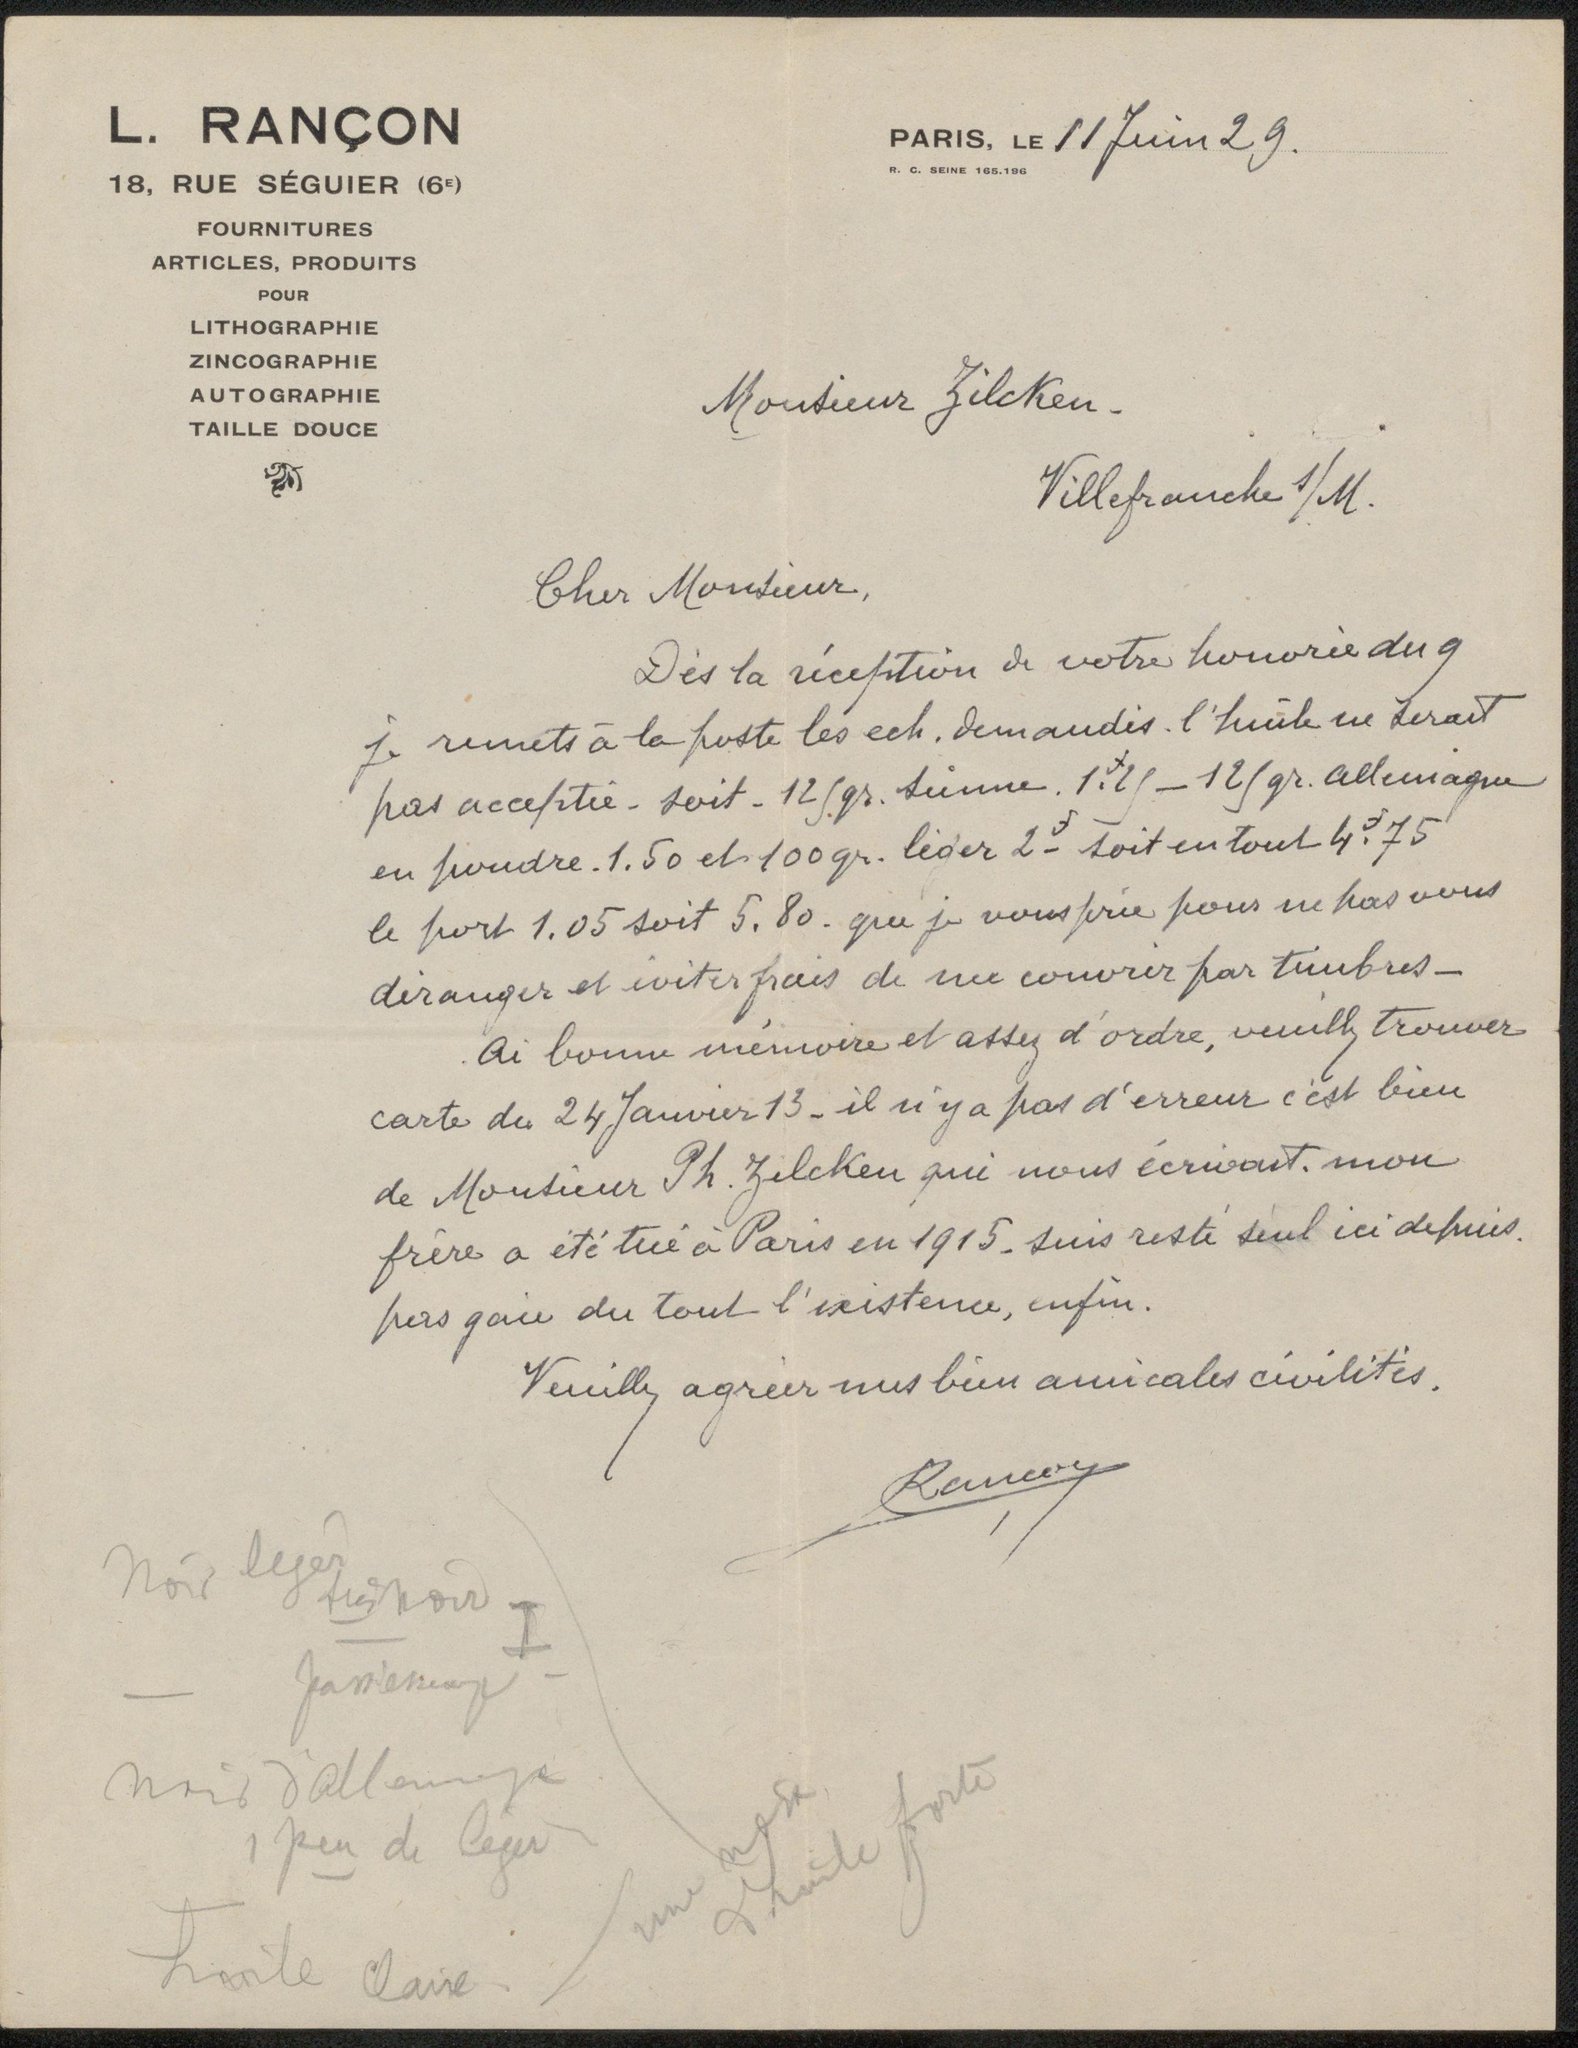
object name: letter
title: Brief aan Philip Zilcken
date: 1929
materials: ink, paper, pencil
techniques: pen, printing, writing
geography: paris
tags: the hague, painter, draughtsman, philip zilcken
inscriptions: collector's mark: ‘RPK’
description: Brief bevat aantekening van Philip Zilcken.